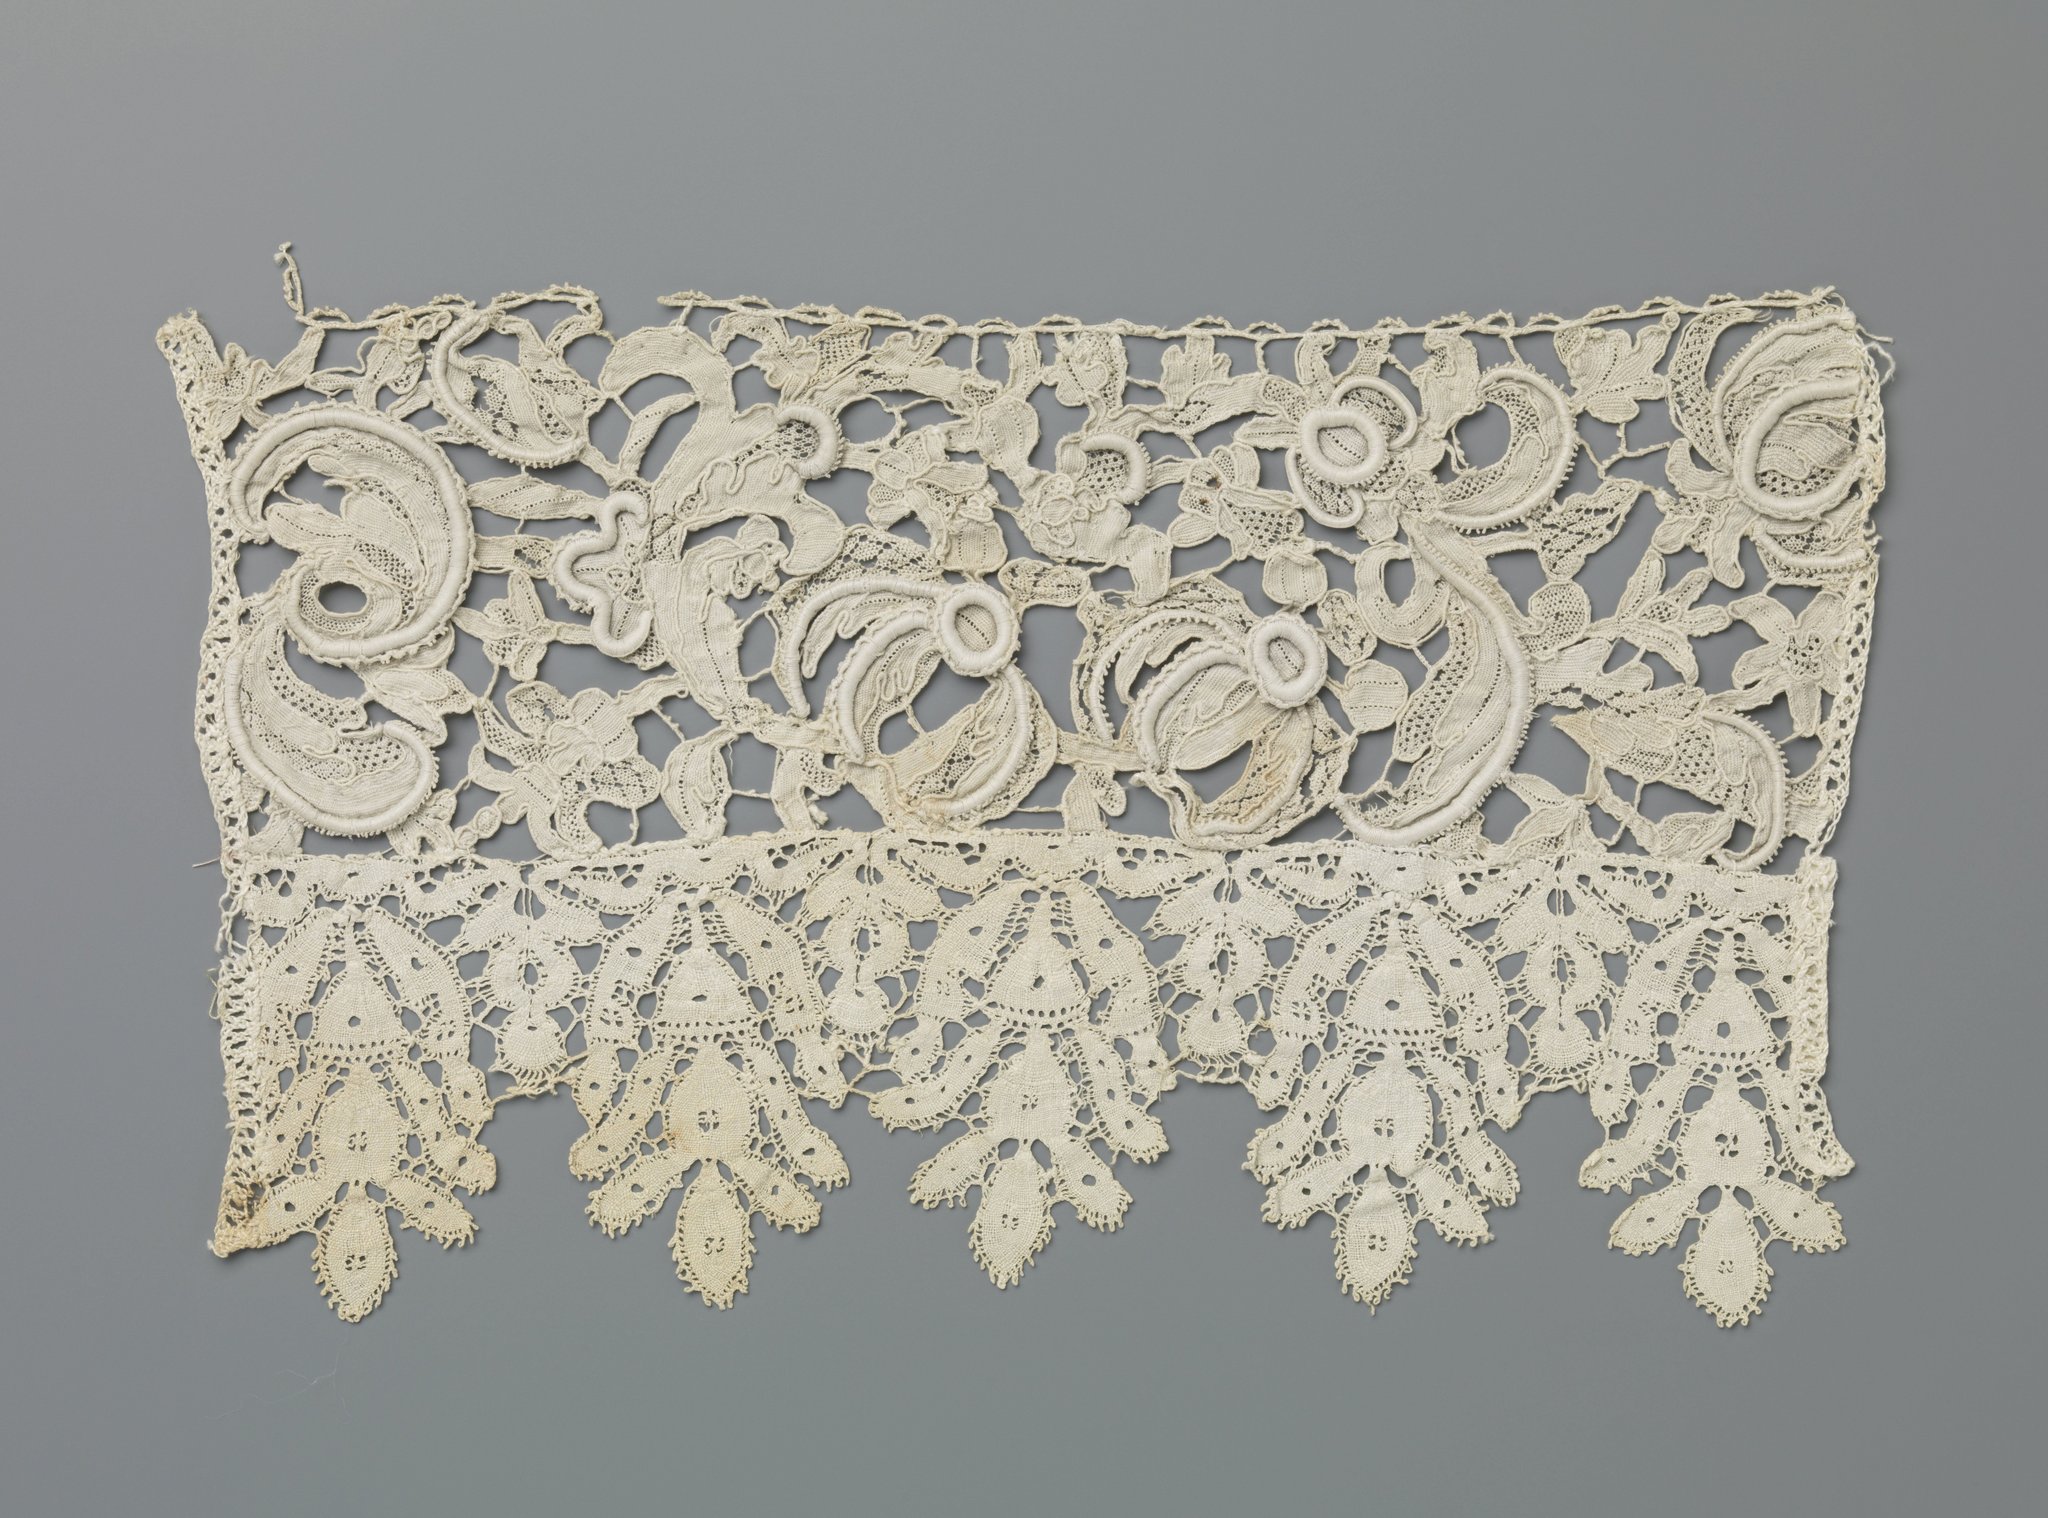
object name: menswear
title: Manchet van naaldkant met afhangende punten van kloskant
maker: Anonymous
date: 1600-1624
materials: linen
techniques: lace, gros point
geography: southern netherlands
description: Manchet van naturelkleurige Venetiaanse naaldkant "gros point", afgezet met een strook oudvlaamse kloskant. Het naaldkant heeft een patroon van bloemen en voluten. De motieven zijn voorzien van contourdraden en gedeeltelijk van dikke cordons, versierd met pictos. Er zijn binnen elk motief verschillende siersteken gebruikt. Het kloskantpatroon bestaat uit hangende kelkbloemen, mogelijk tulpen. De motieven zijn gemaakt in linnenslag met opengewerkte randjes en uitsparingen. De bovenzijde van het manchet is afgewerkt met een boogjesrandje (naaldkant). De gekloste schulpen zijn afgewerkt met picots. En de korte zijden zijn afgewerkt met een geklost bandje. De schulpenrand van kloskant is vermoedelijk ouder dan het naaldkant en is vervaardigd in de Zuidelijke Nederlanden. Het naaldkant is vervaardigd in Italië. De kanten zijn tot manchet samengesteld in de 19de eeuw.